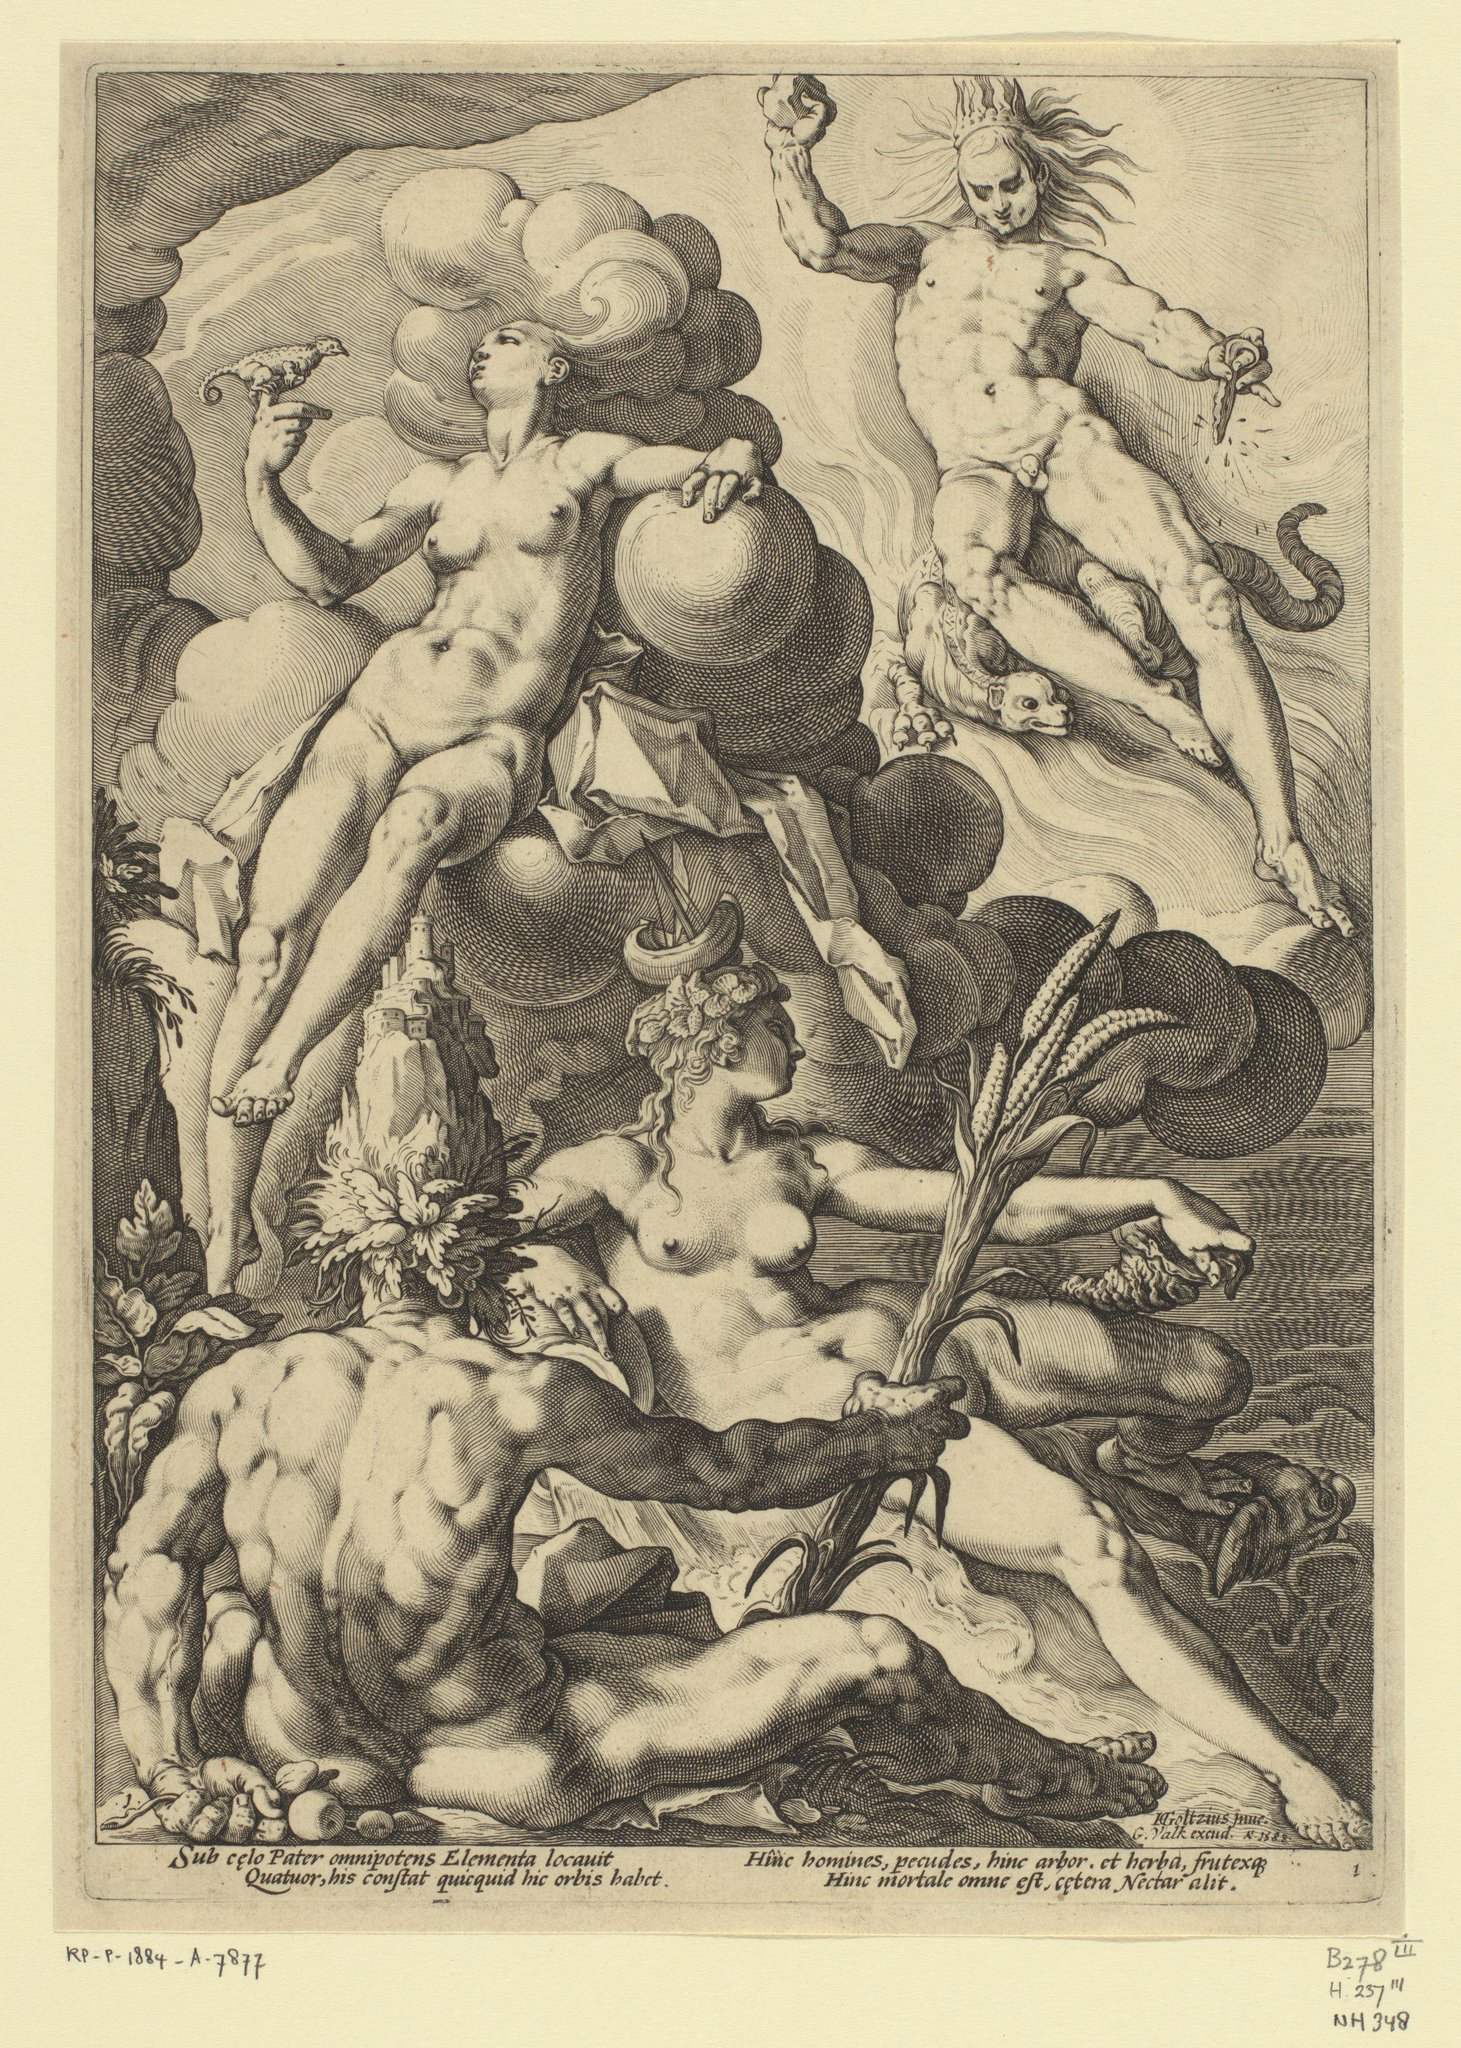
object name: print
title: De vier elementen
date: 1588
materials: paper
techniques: engraving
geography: amsterdam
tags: the four elements, and ether, the fifth element (+ variant)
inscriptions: collector's mark: Lugt 2228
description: De vier elementen Aarde, Water, Lucht en Vuur, gepersonifieerd als twee vrouwelijke en twee mannelijke figuren. Links op de voorgrond, op de rug gezien, zit Aarde (Terra) met in zijn hand korenschoven. Tevens op de voorgrond zit Water (Aqua) als vrouwenfiguur met op haar hoofd een schip en naast haar een stroom. In de lucht tussen de wolken zit Lucht (Aer) met op haar hand een kameleon. Rechtsachter een mannenfiguur dat Vuur (Ignis) verbeeldt, zittend op een draak en op zijn hoofd een kroon van vlammen. Achter zijn hoofd de zon.